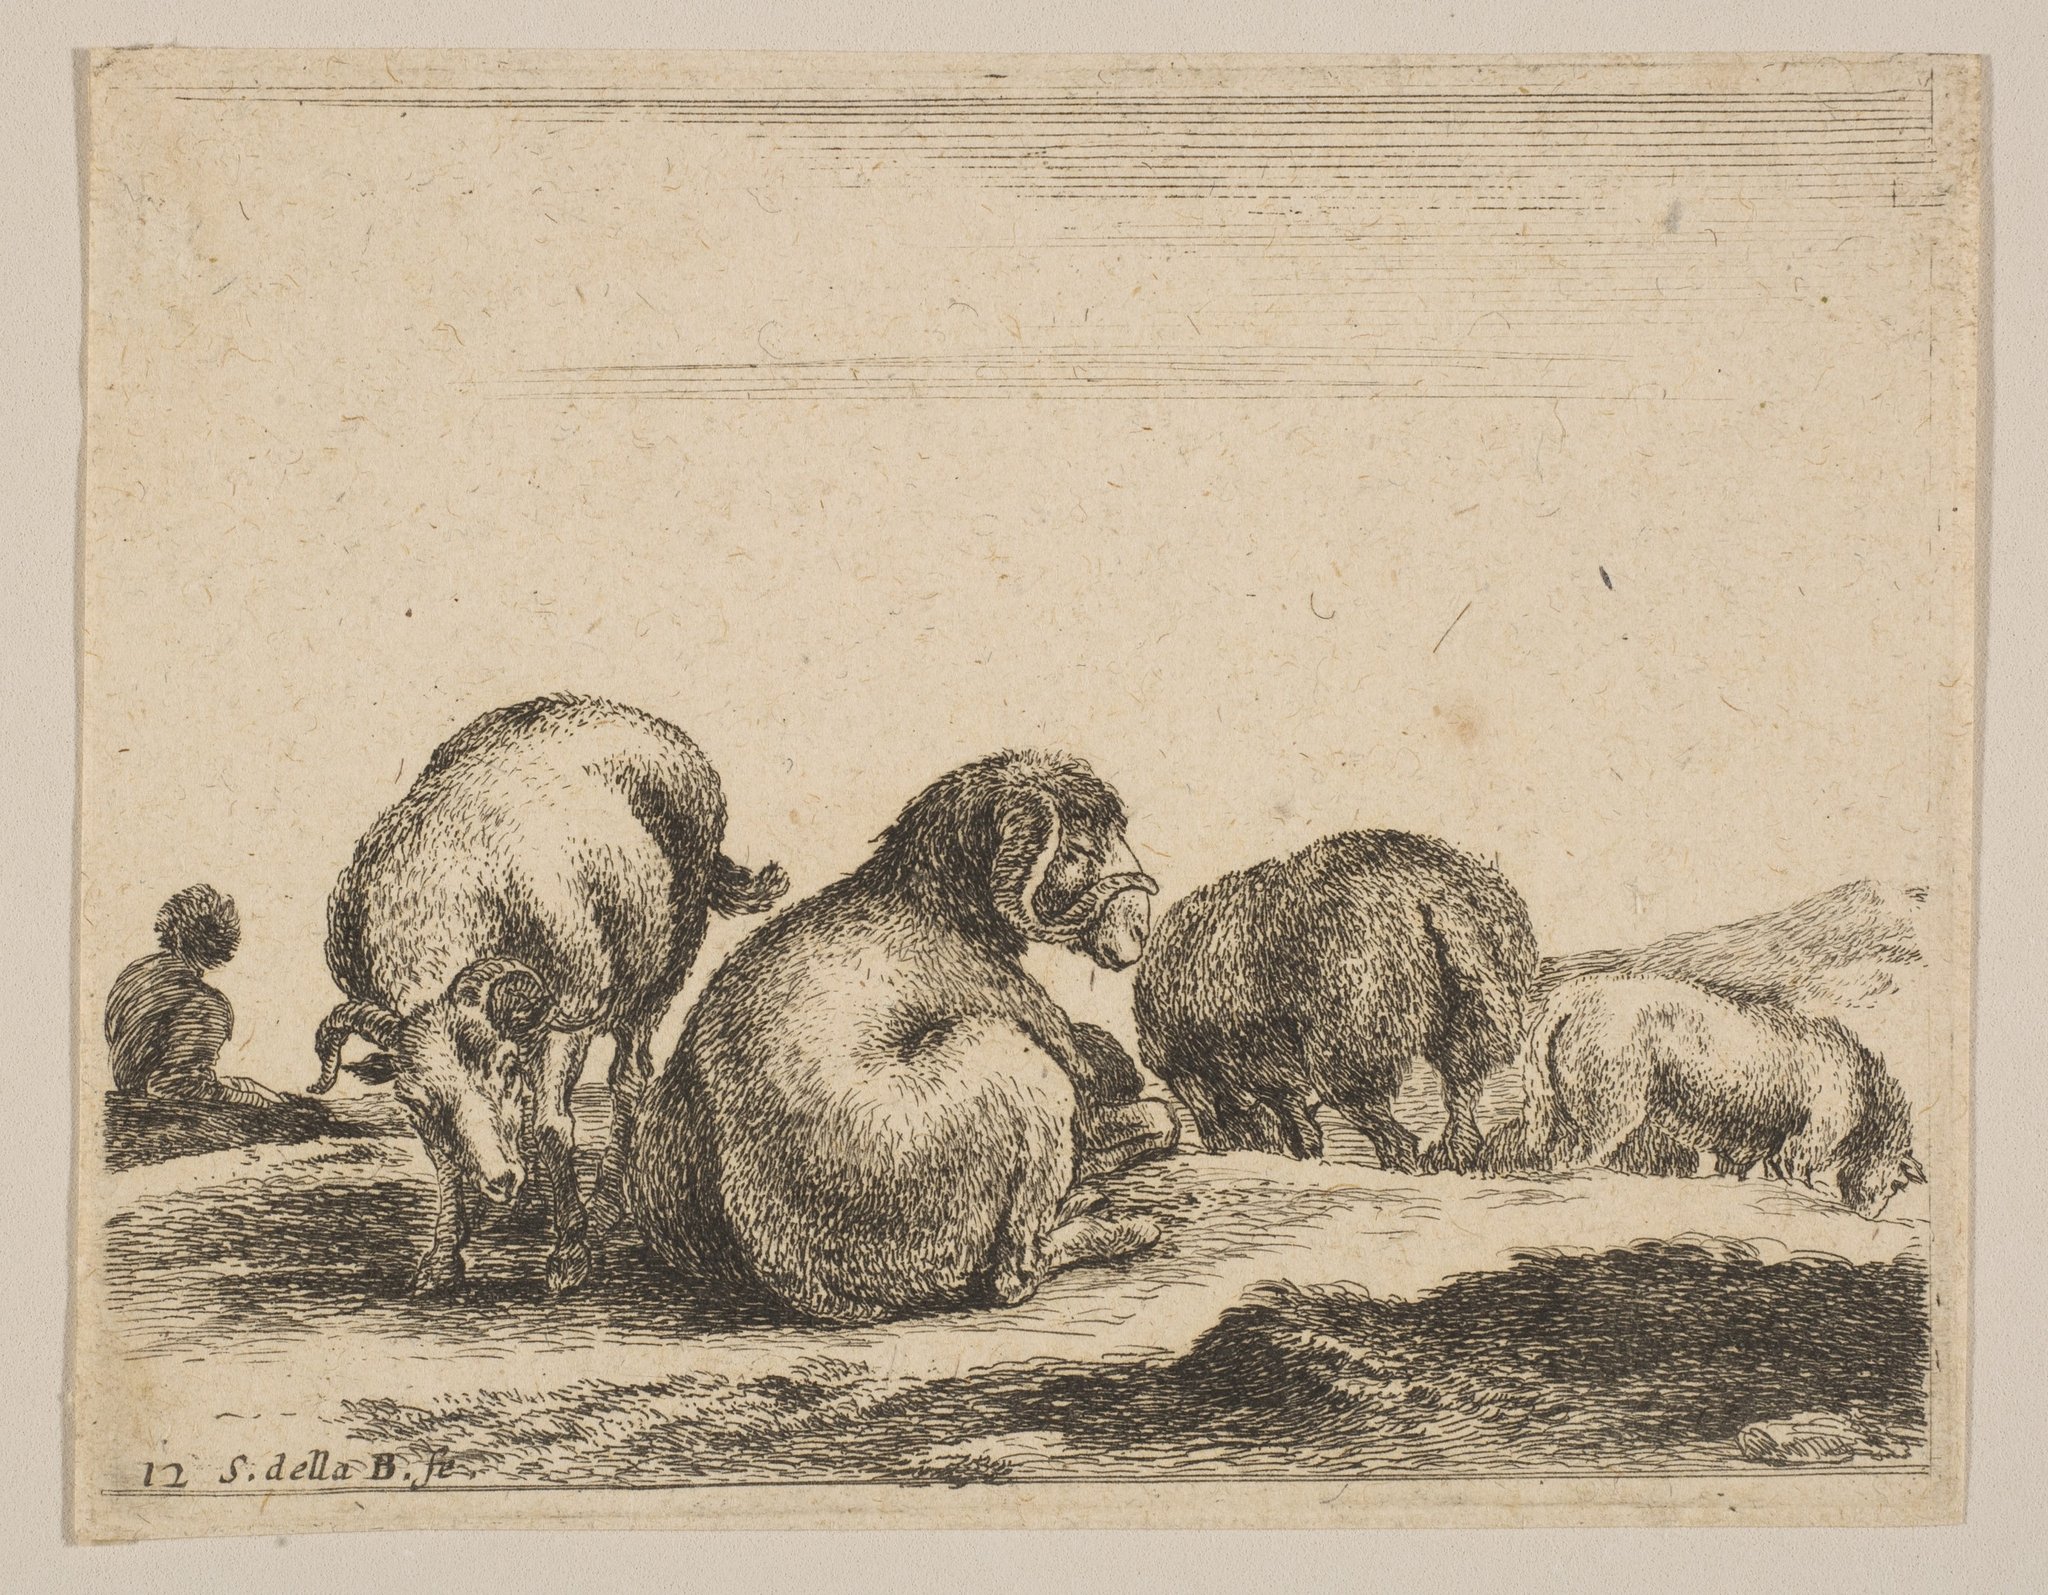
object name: print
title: Plate 12: Sheep and ram in a pasture, from "Various animals" (Diversi animali)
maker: stefano della bella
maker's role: artist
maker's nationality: italian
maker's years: 1610-1664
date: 1641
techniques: etching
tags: rams,sheep